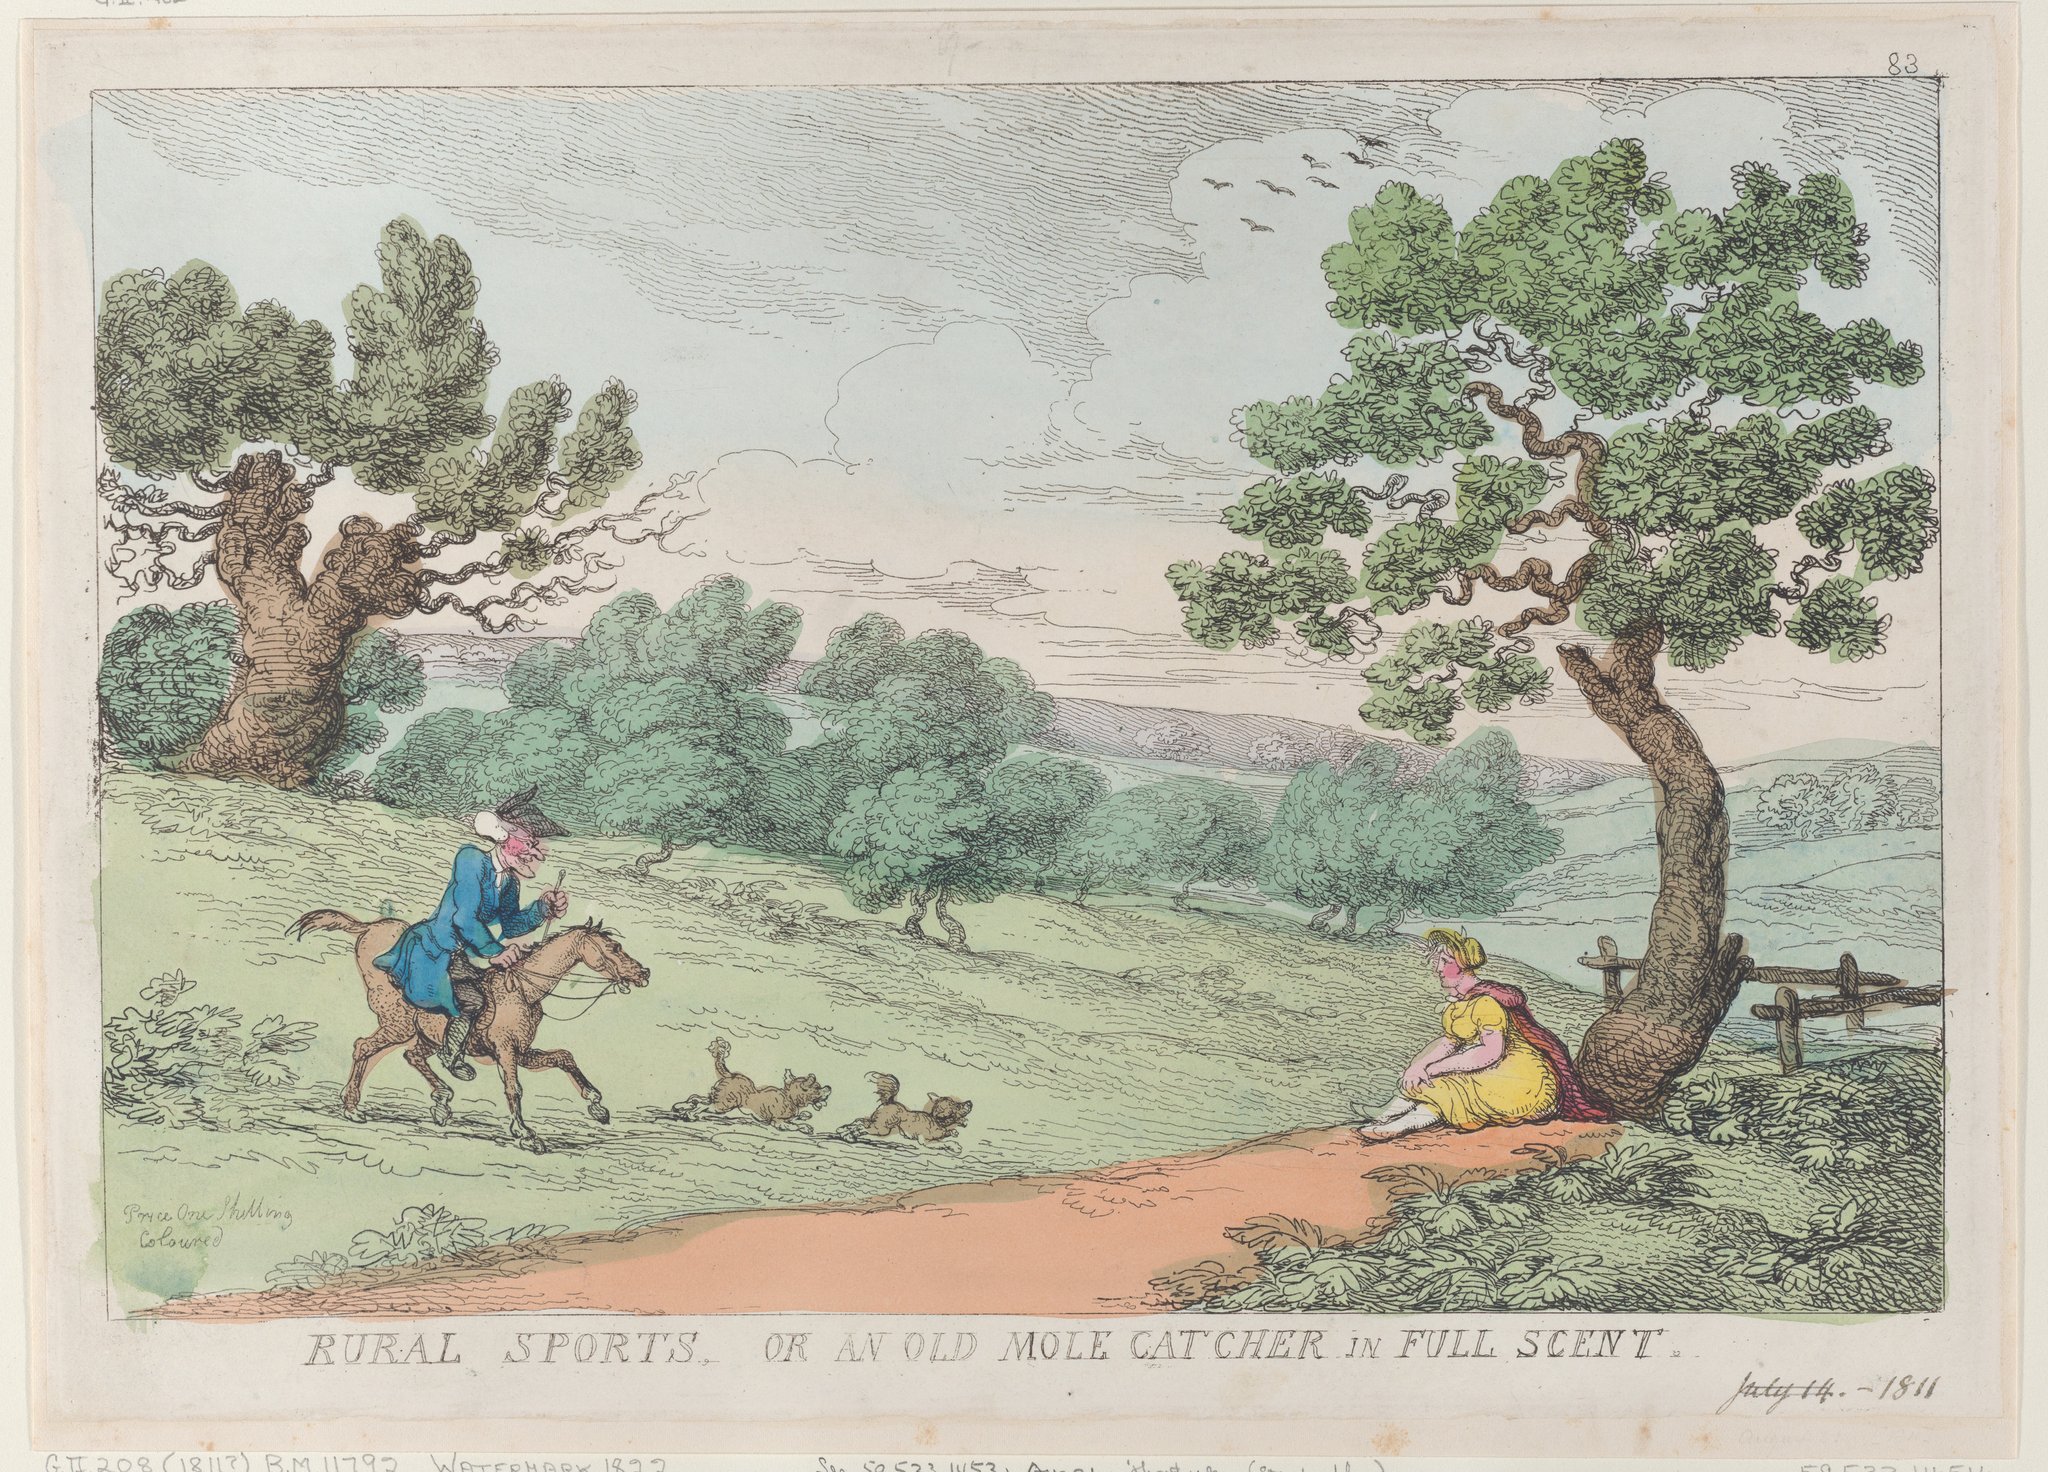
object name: print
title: Rural Sports, or an Old Mole Catcher in Full Scent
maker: thomas rowlandson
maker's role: artist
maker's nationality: british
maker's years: 1757-1827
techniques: etching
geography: london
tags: satire,men,women,dogs,horses,landscapes